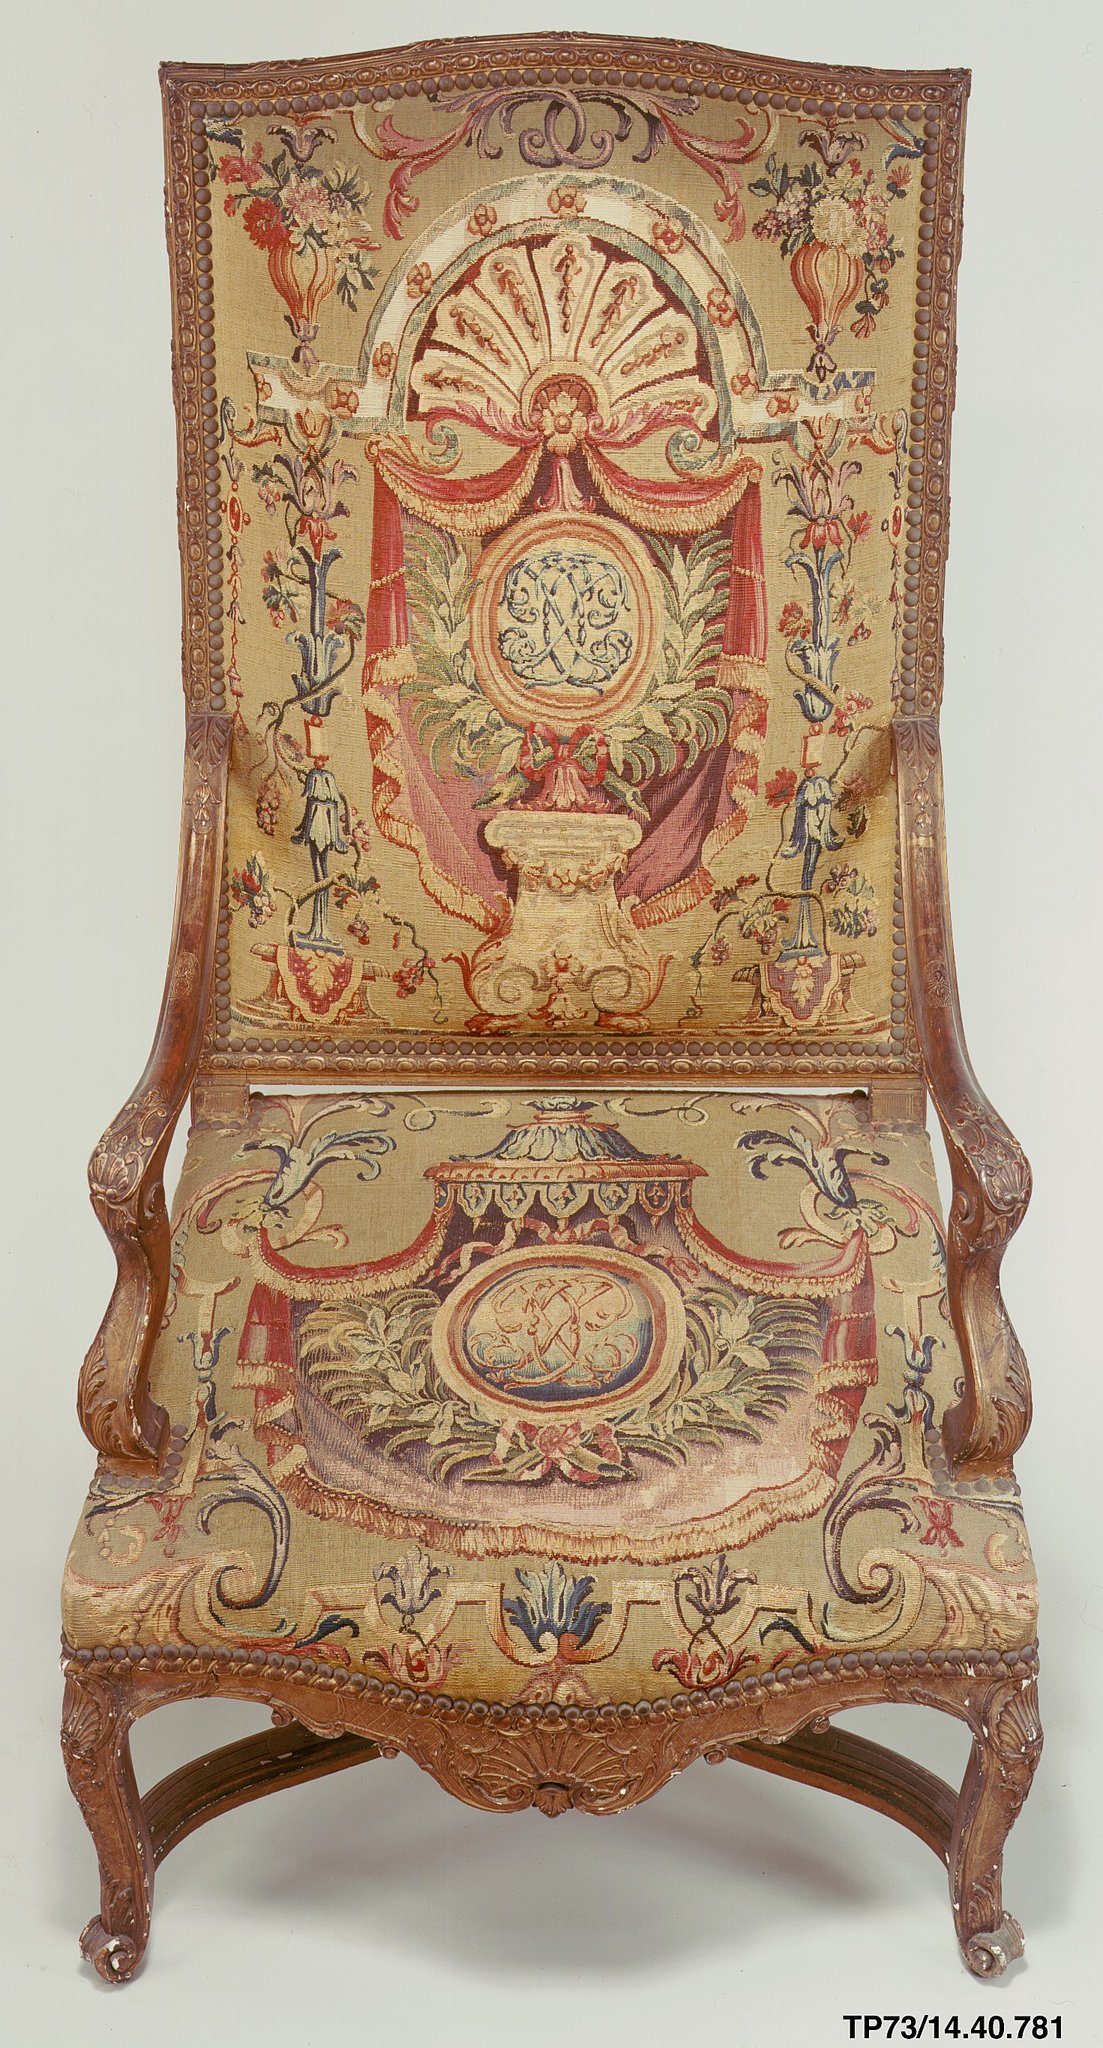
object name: armchair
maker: beauvais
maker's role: factory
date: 1715-1720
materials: wood, silk, wool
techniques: carving, gilding, tapestry